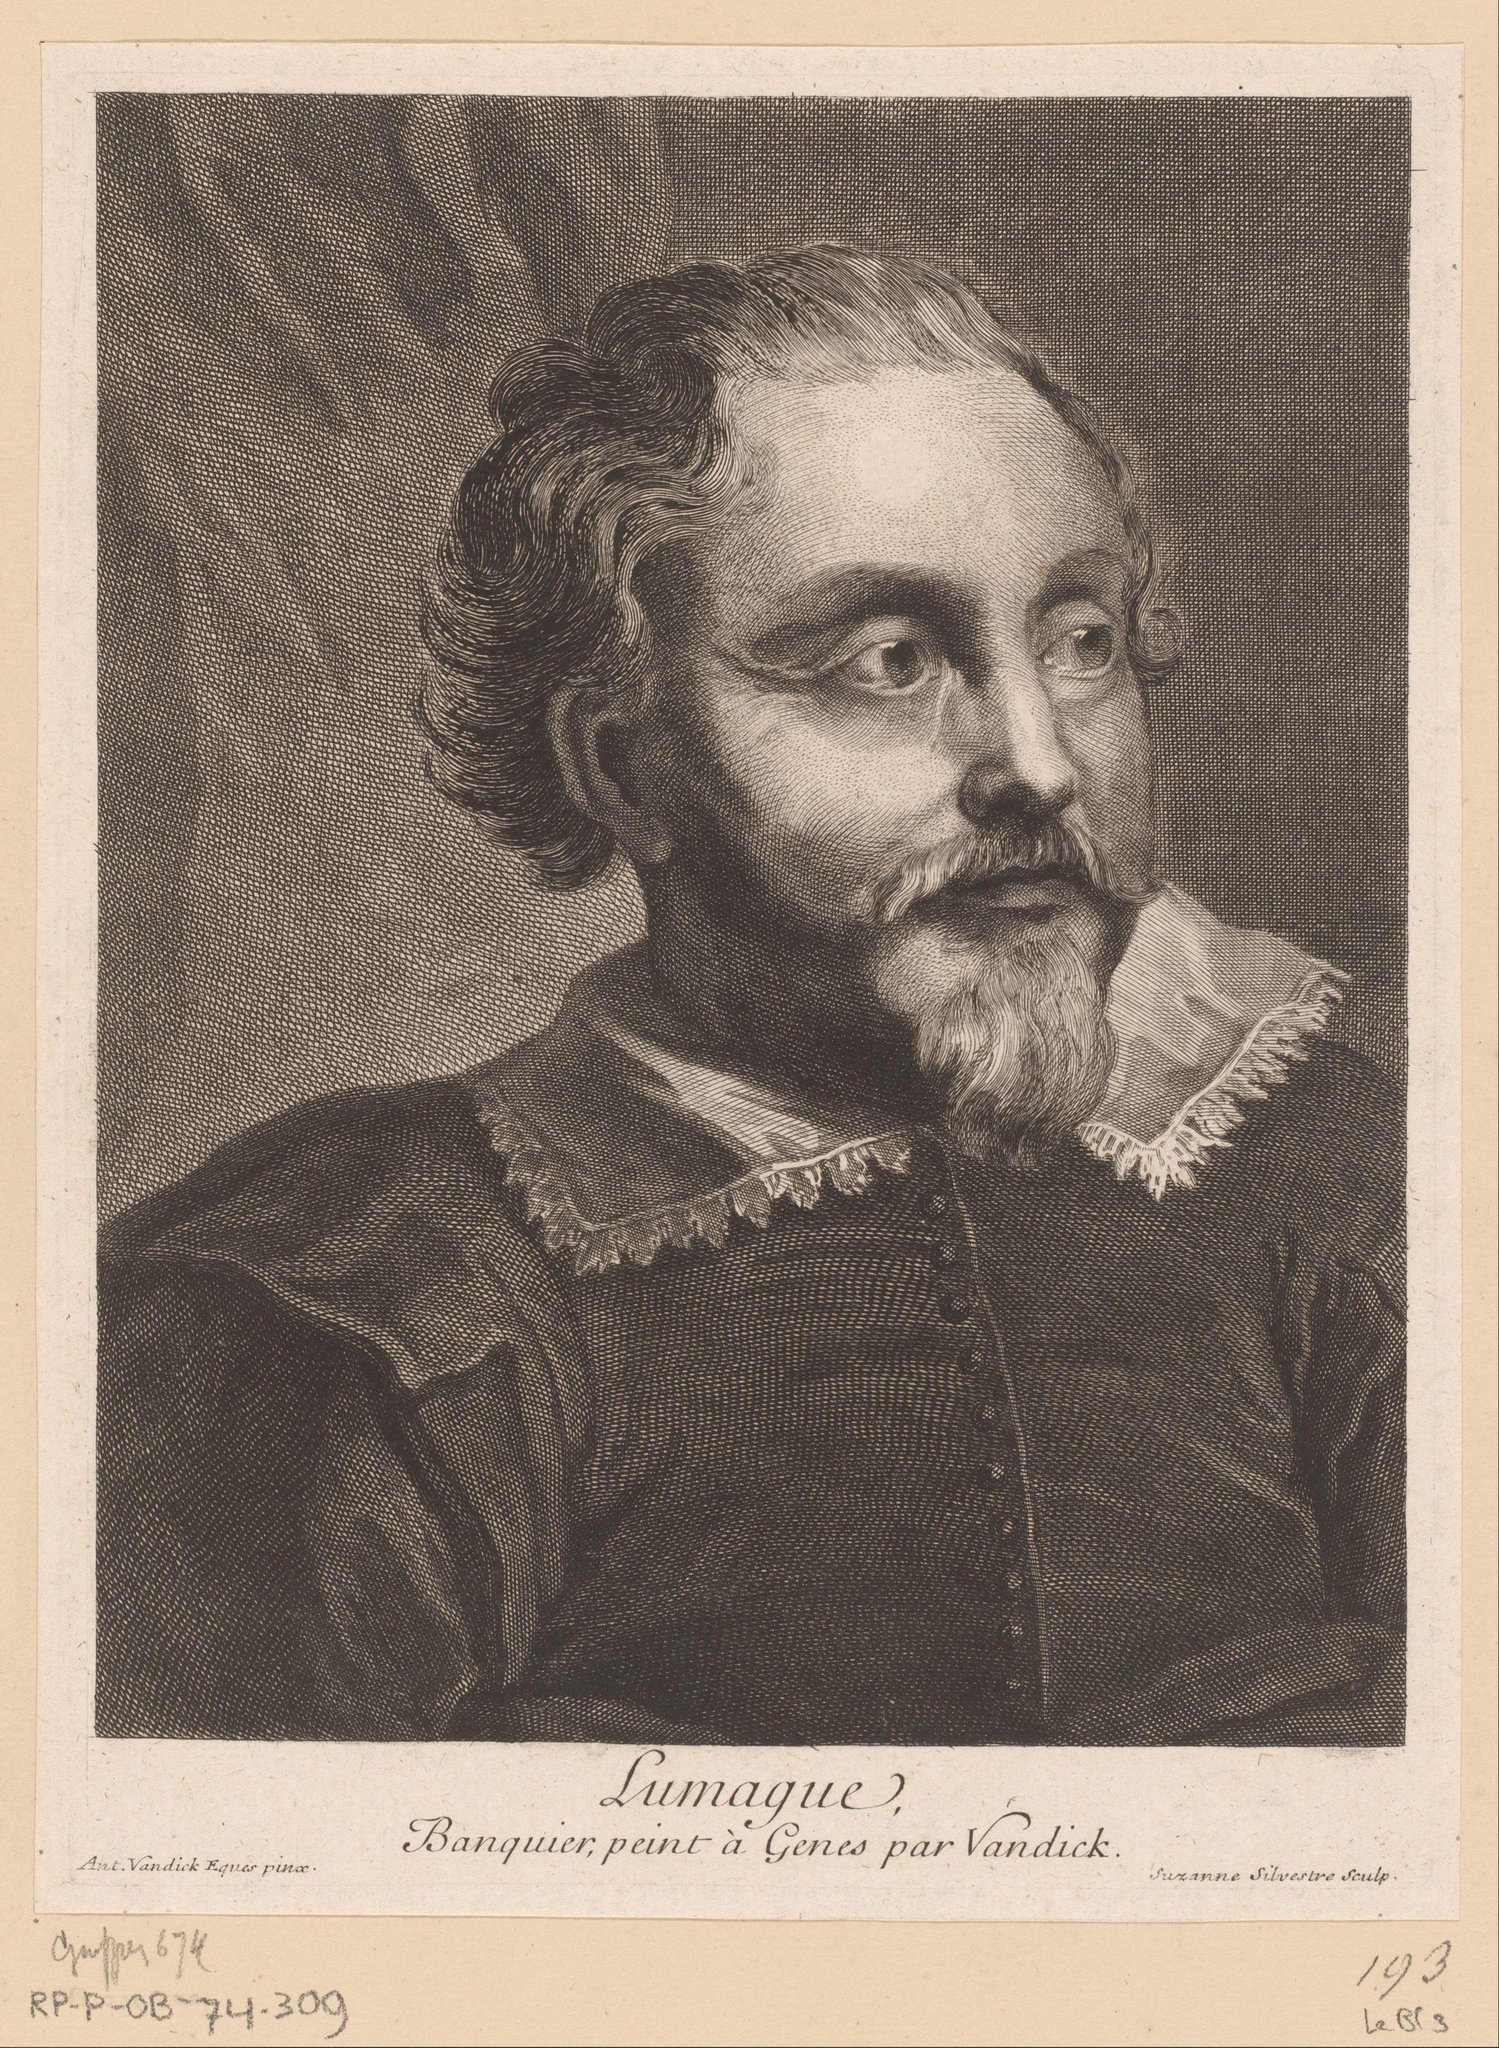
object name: print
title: Portret van Marc Antoine Lumague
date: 1704-1738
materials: paper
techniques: engraving, etching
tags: historical persons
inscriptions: collector's mark: Lugt 240